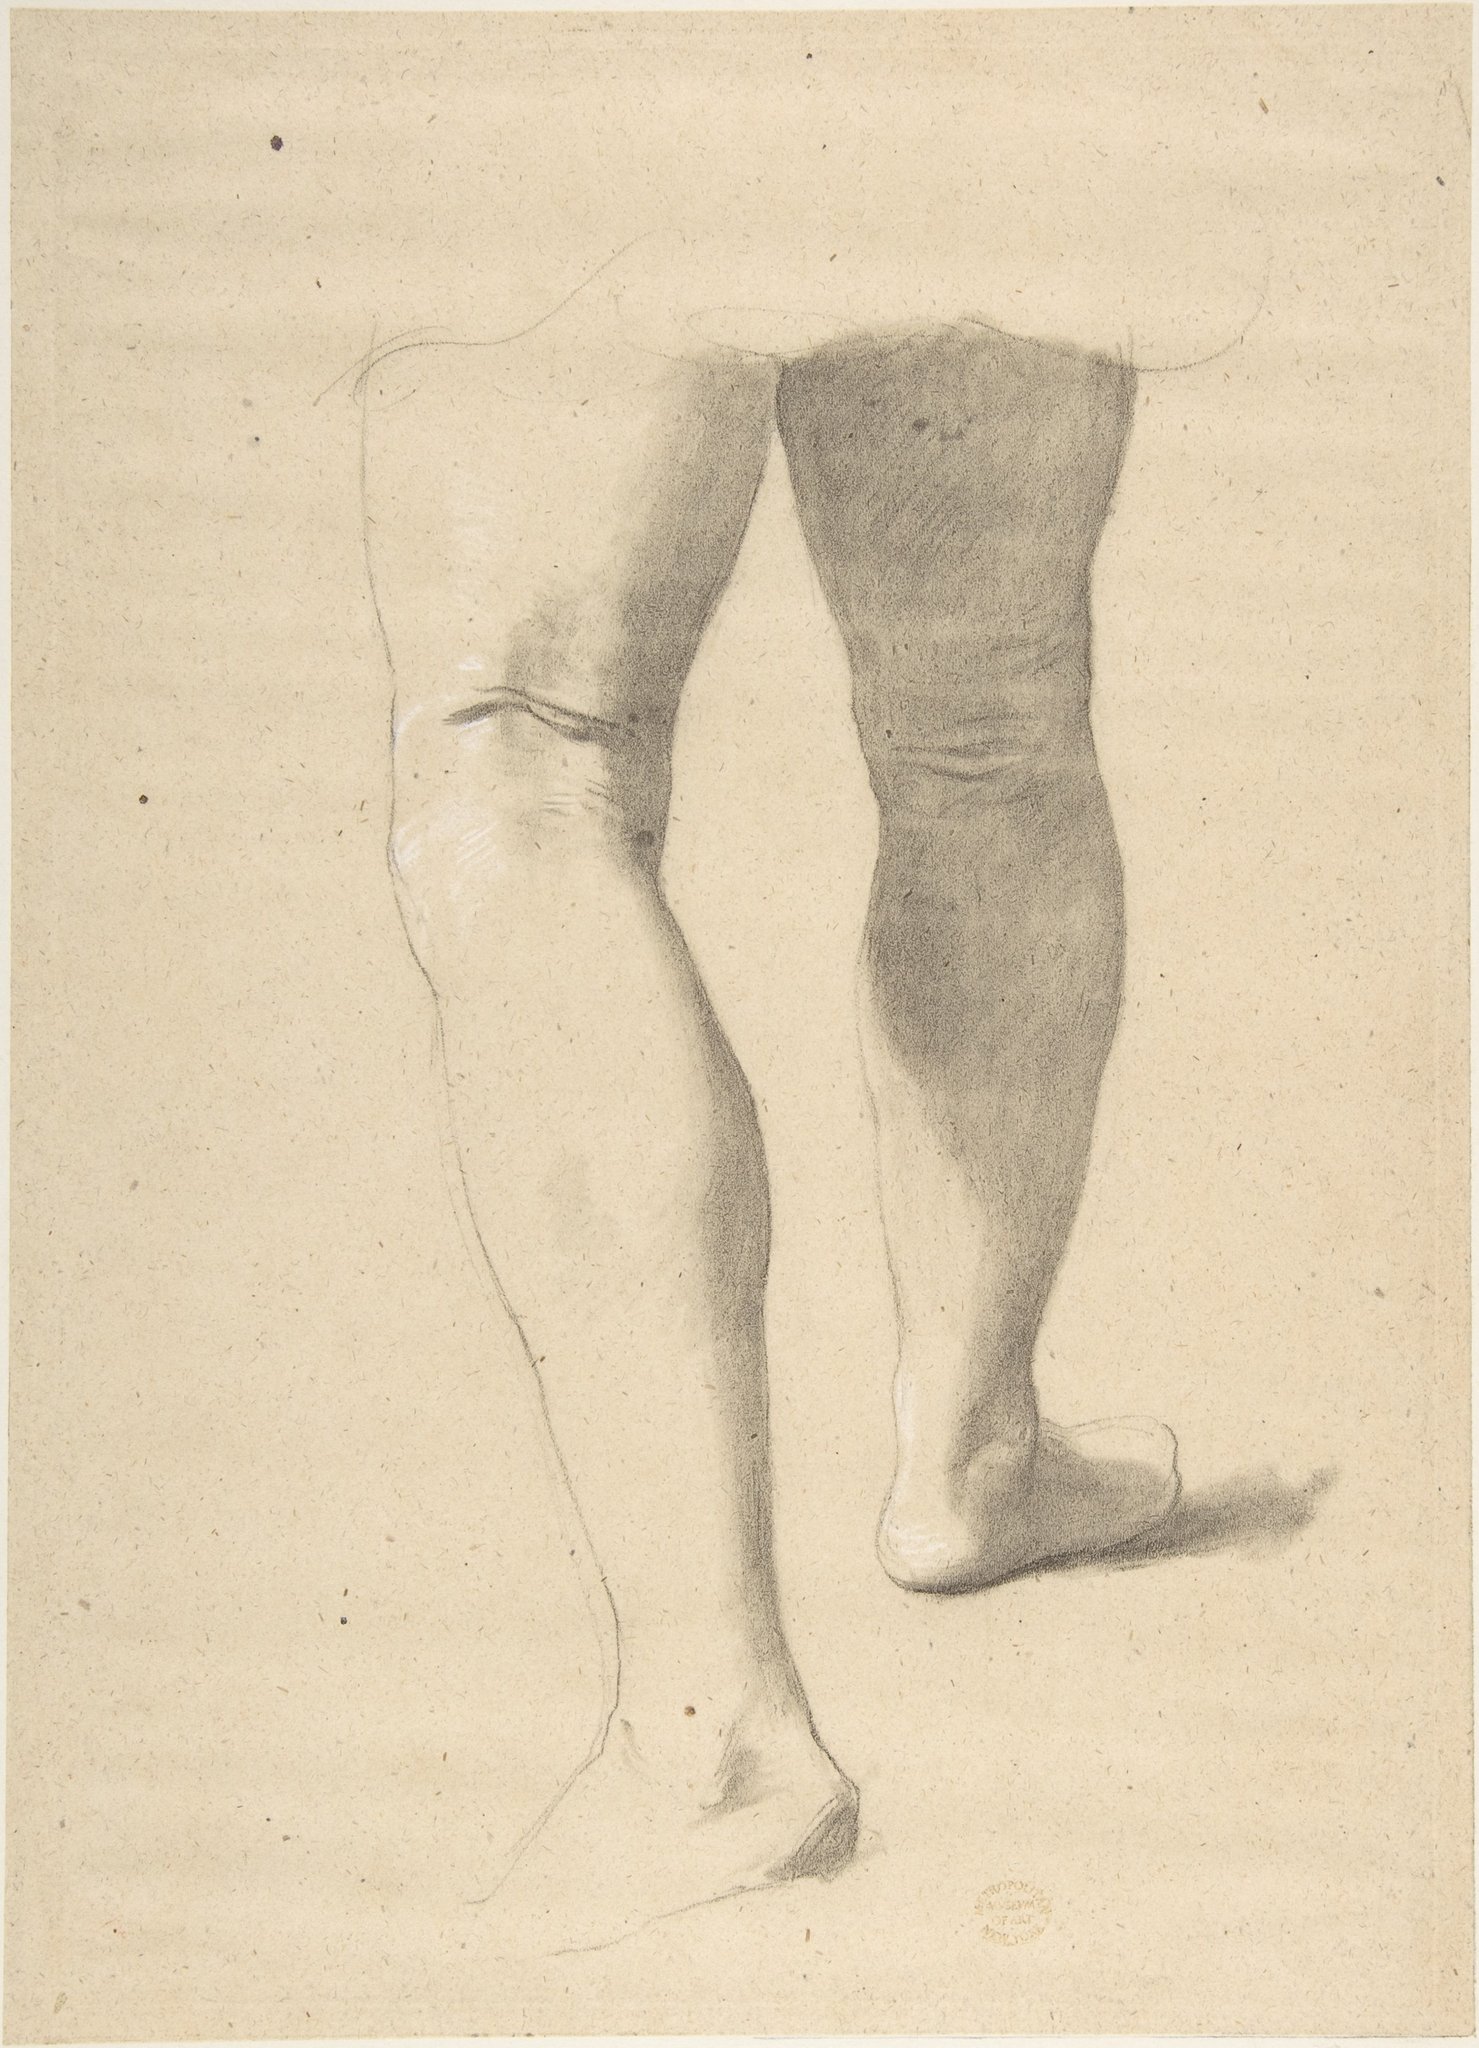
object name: drawing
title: Study of Legs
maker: romain cazes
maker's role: artist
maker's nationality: french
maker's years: 1808-1881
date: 1828-1881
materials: chalk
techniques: highlighting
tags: feet